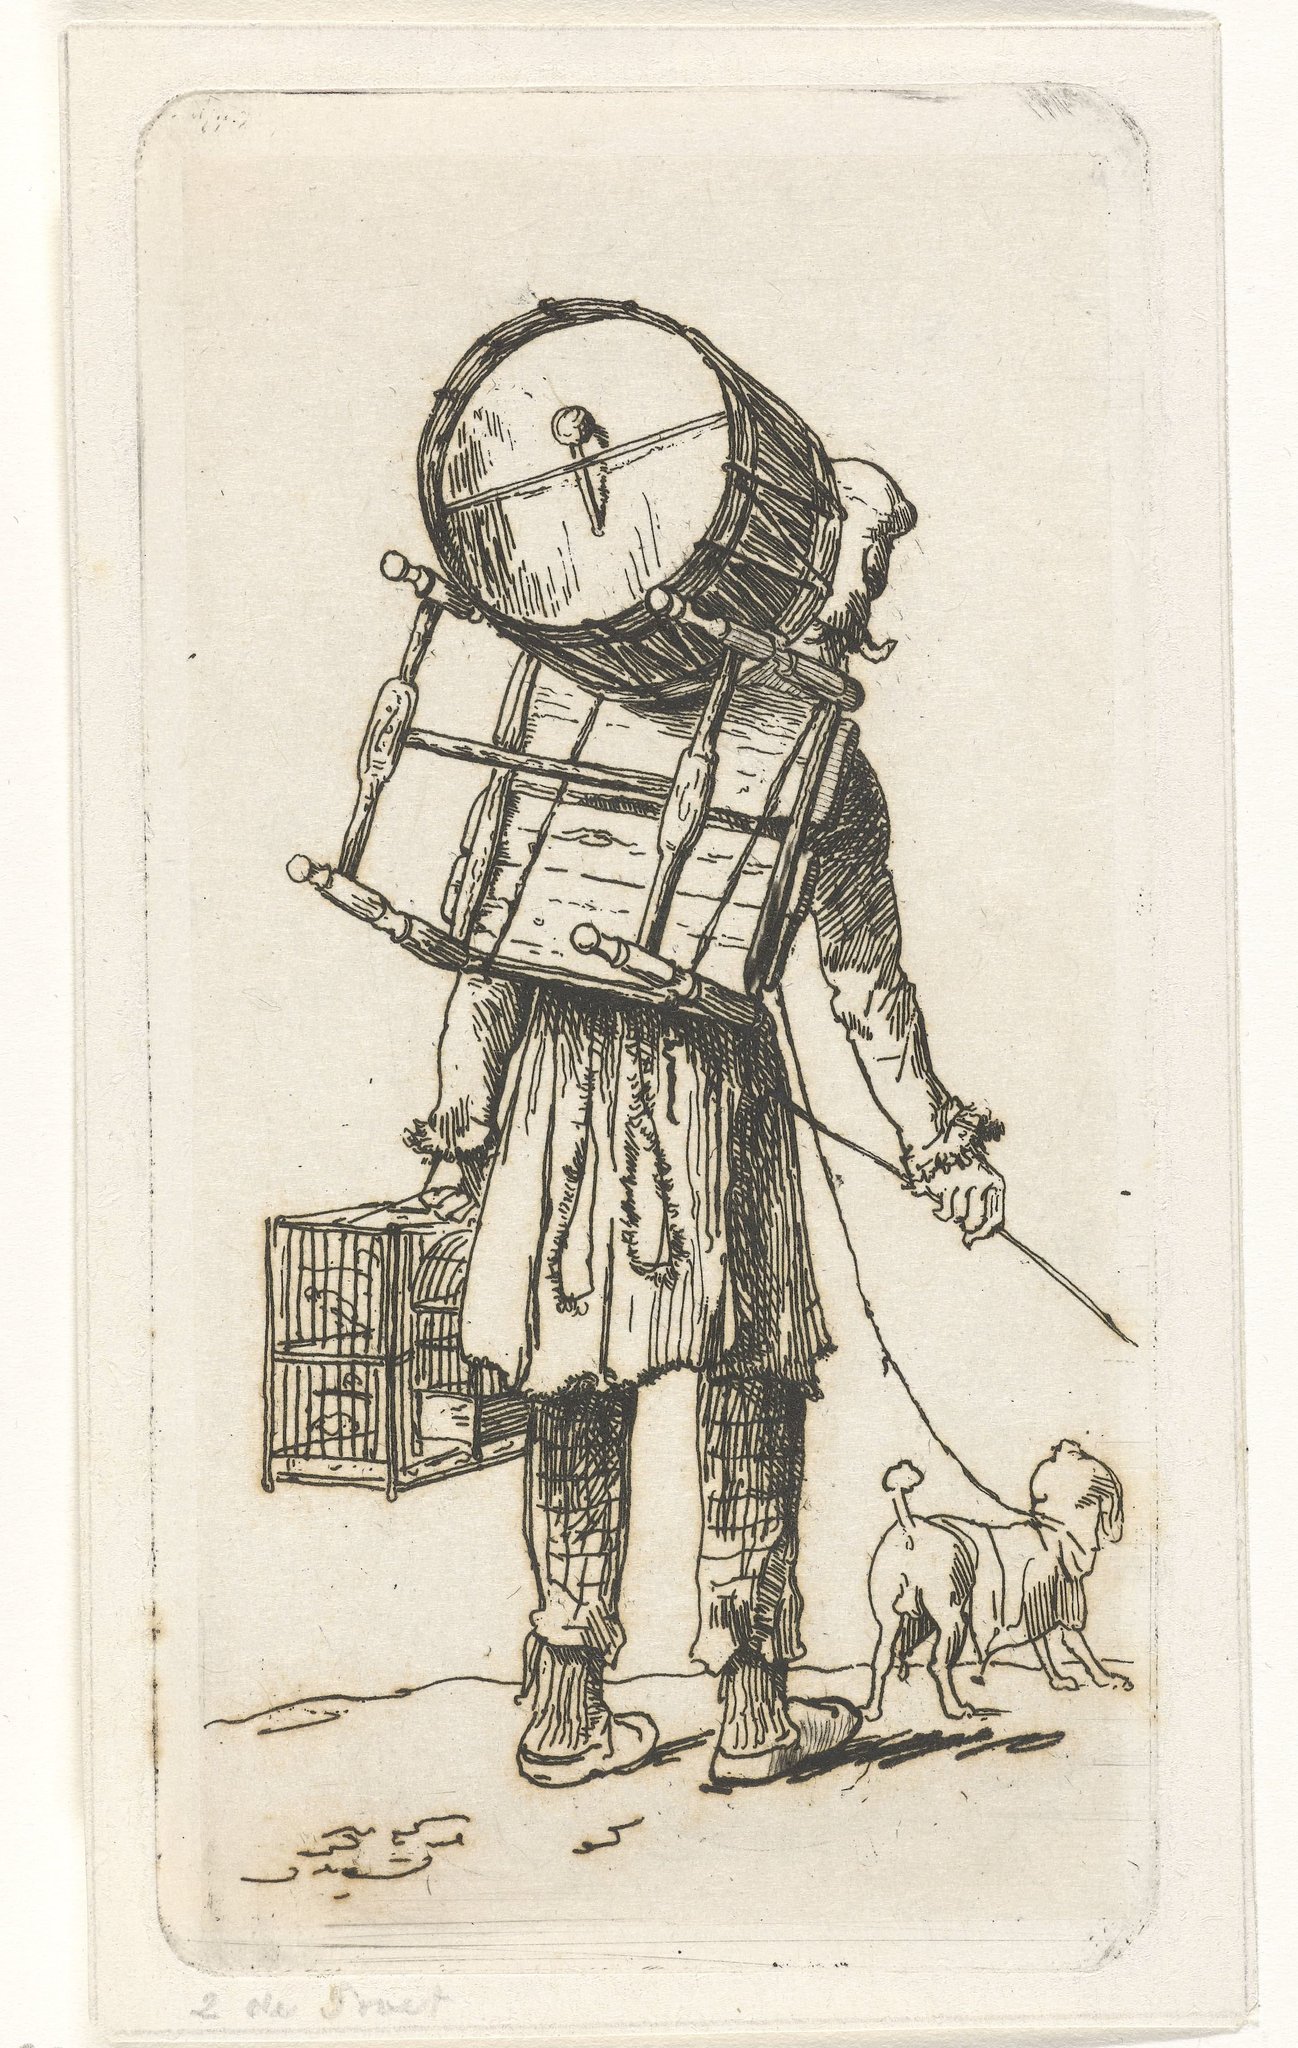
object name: print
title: Straatmuzikant met hond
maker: jacobus ludovicus cornet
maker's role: draughtsman, print maker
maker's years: 1815-1882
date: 1825-1882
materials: paper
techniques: etching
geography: leiden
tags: drum (musical instrument), popular music, street music, circus, dog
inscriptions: collector's mark: Lugt 2228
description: Een straatmuzikant met een trom op zijn rug en een vogelkooi in zijn hand. Naast hem aan de leiband loopt een hondje.